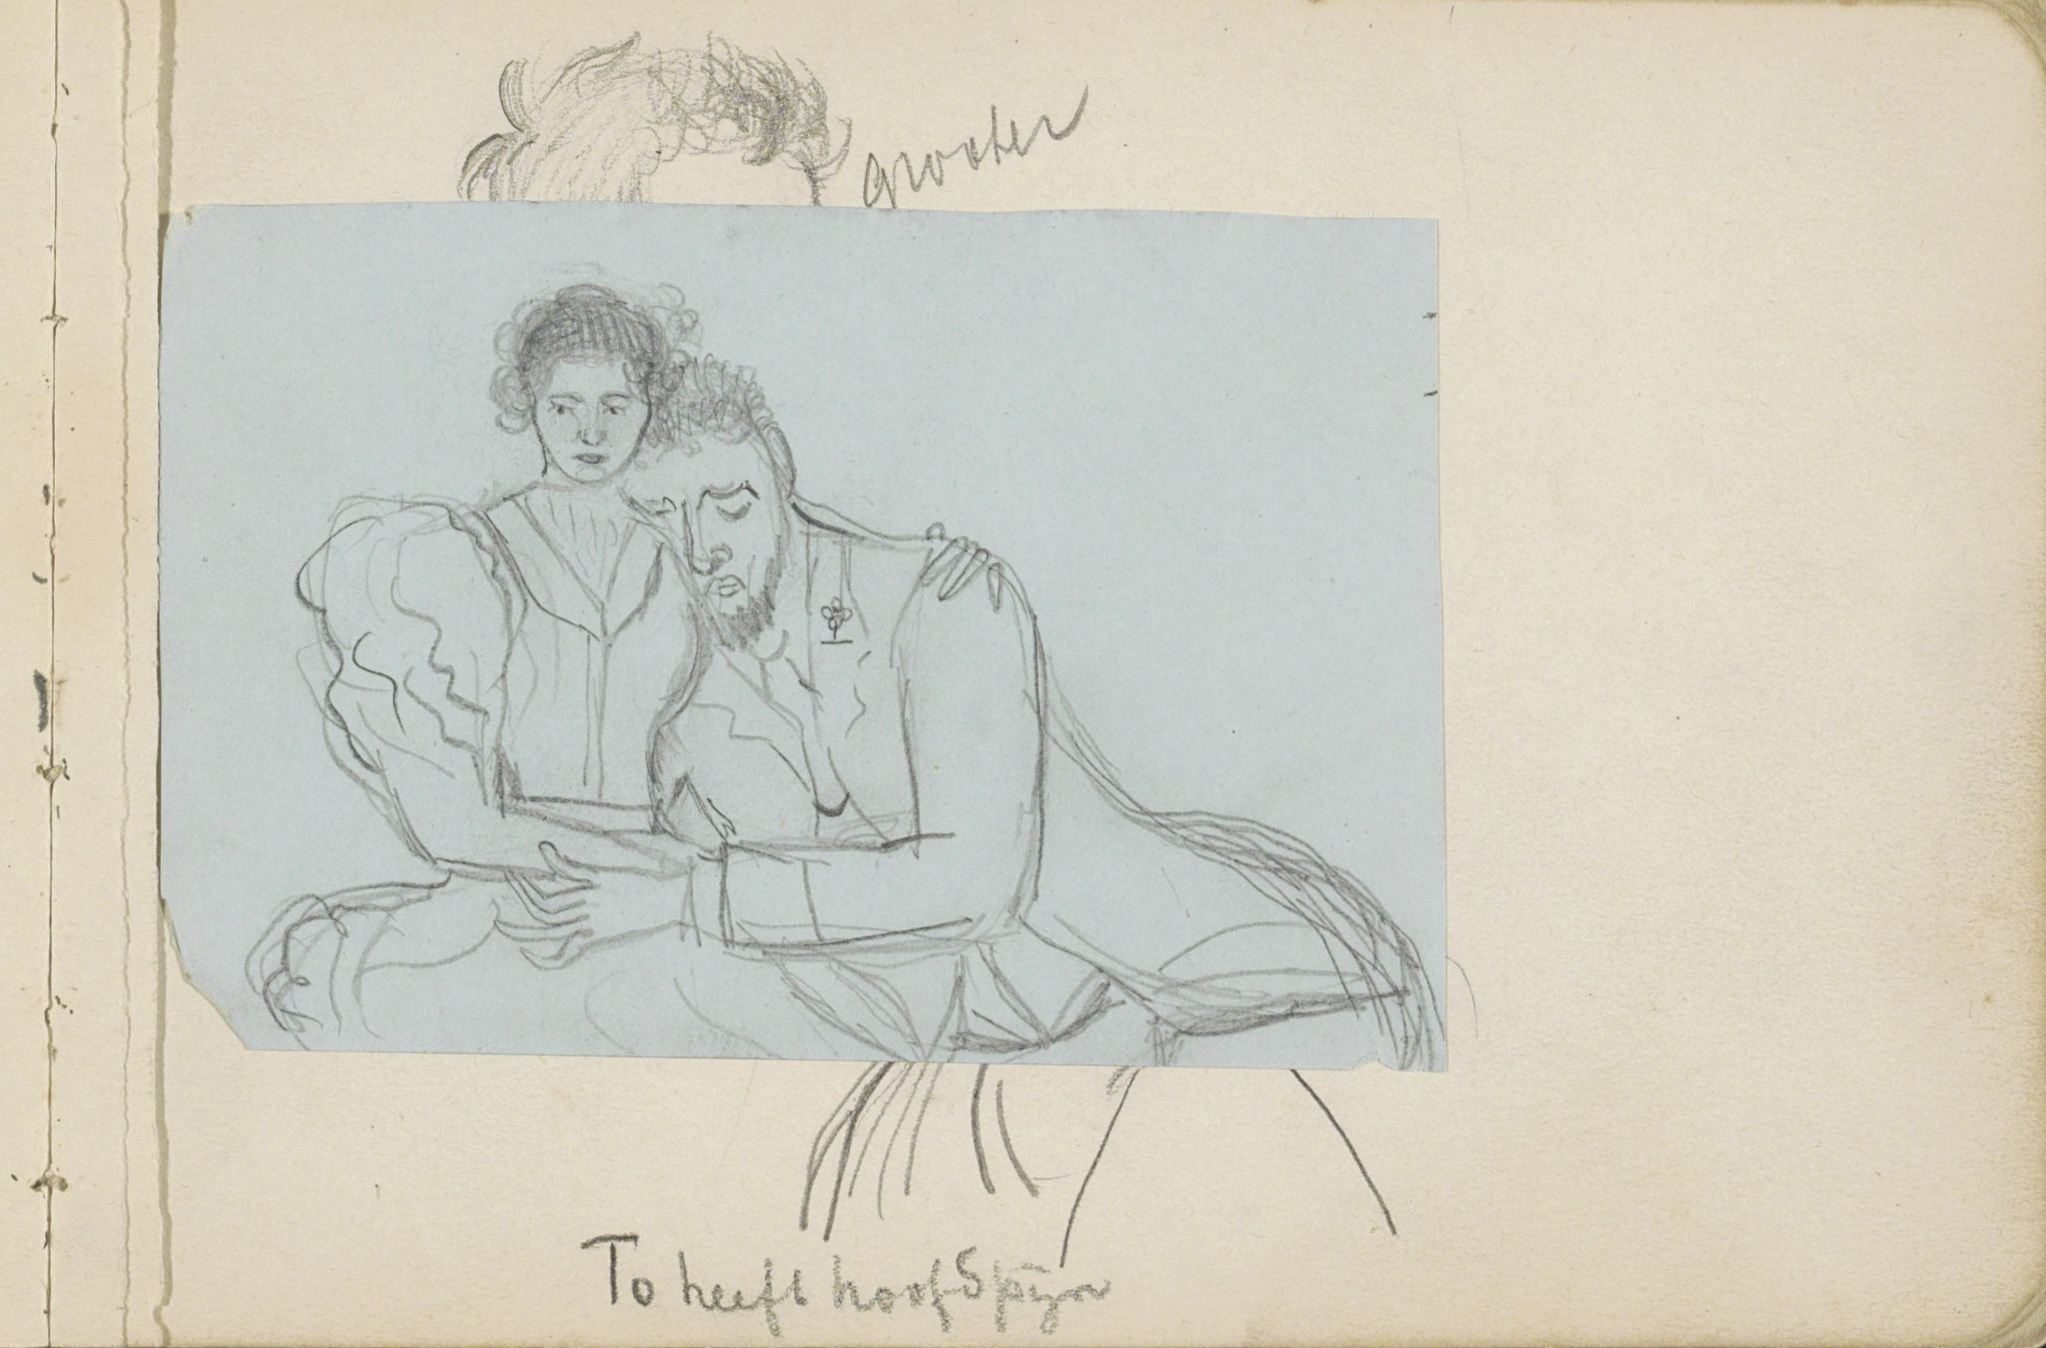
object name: sketchbook leaf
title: Vrouw met de arm om de schouders van een man die tegen haar leunt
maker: julie de graag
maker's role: draughtsman, print maker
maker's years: 1877-1924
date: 1894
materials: paper, pencil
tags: sitting figure, adult woman, hand on shoulder (friends), adult man, eyes closed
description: De man heeft de ogen teneergeslagen en wordt mogelijk getroost door de vrouw. Losse tekening tussen pagina 10 en 11 in een schetsboek met 35 bladen.